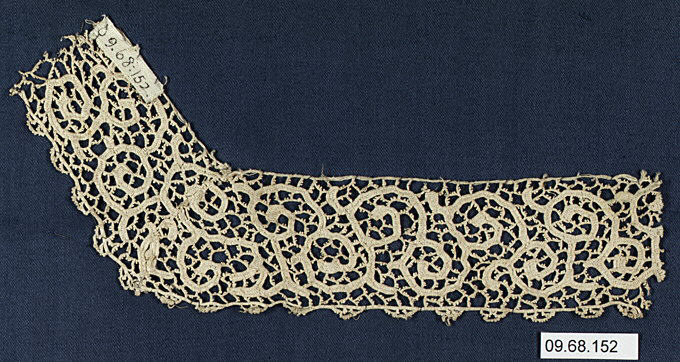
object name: fragment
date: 1701-1800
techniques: lace